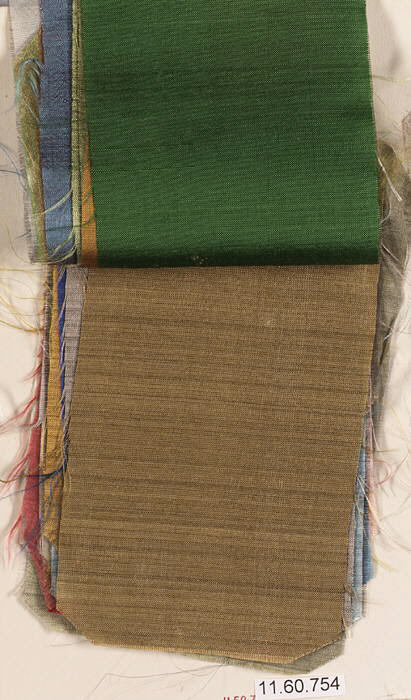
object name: sample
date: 1801-1833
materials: silk